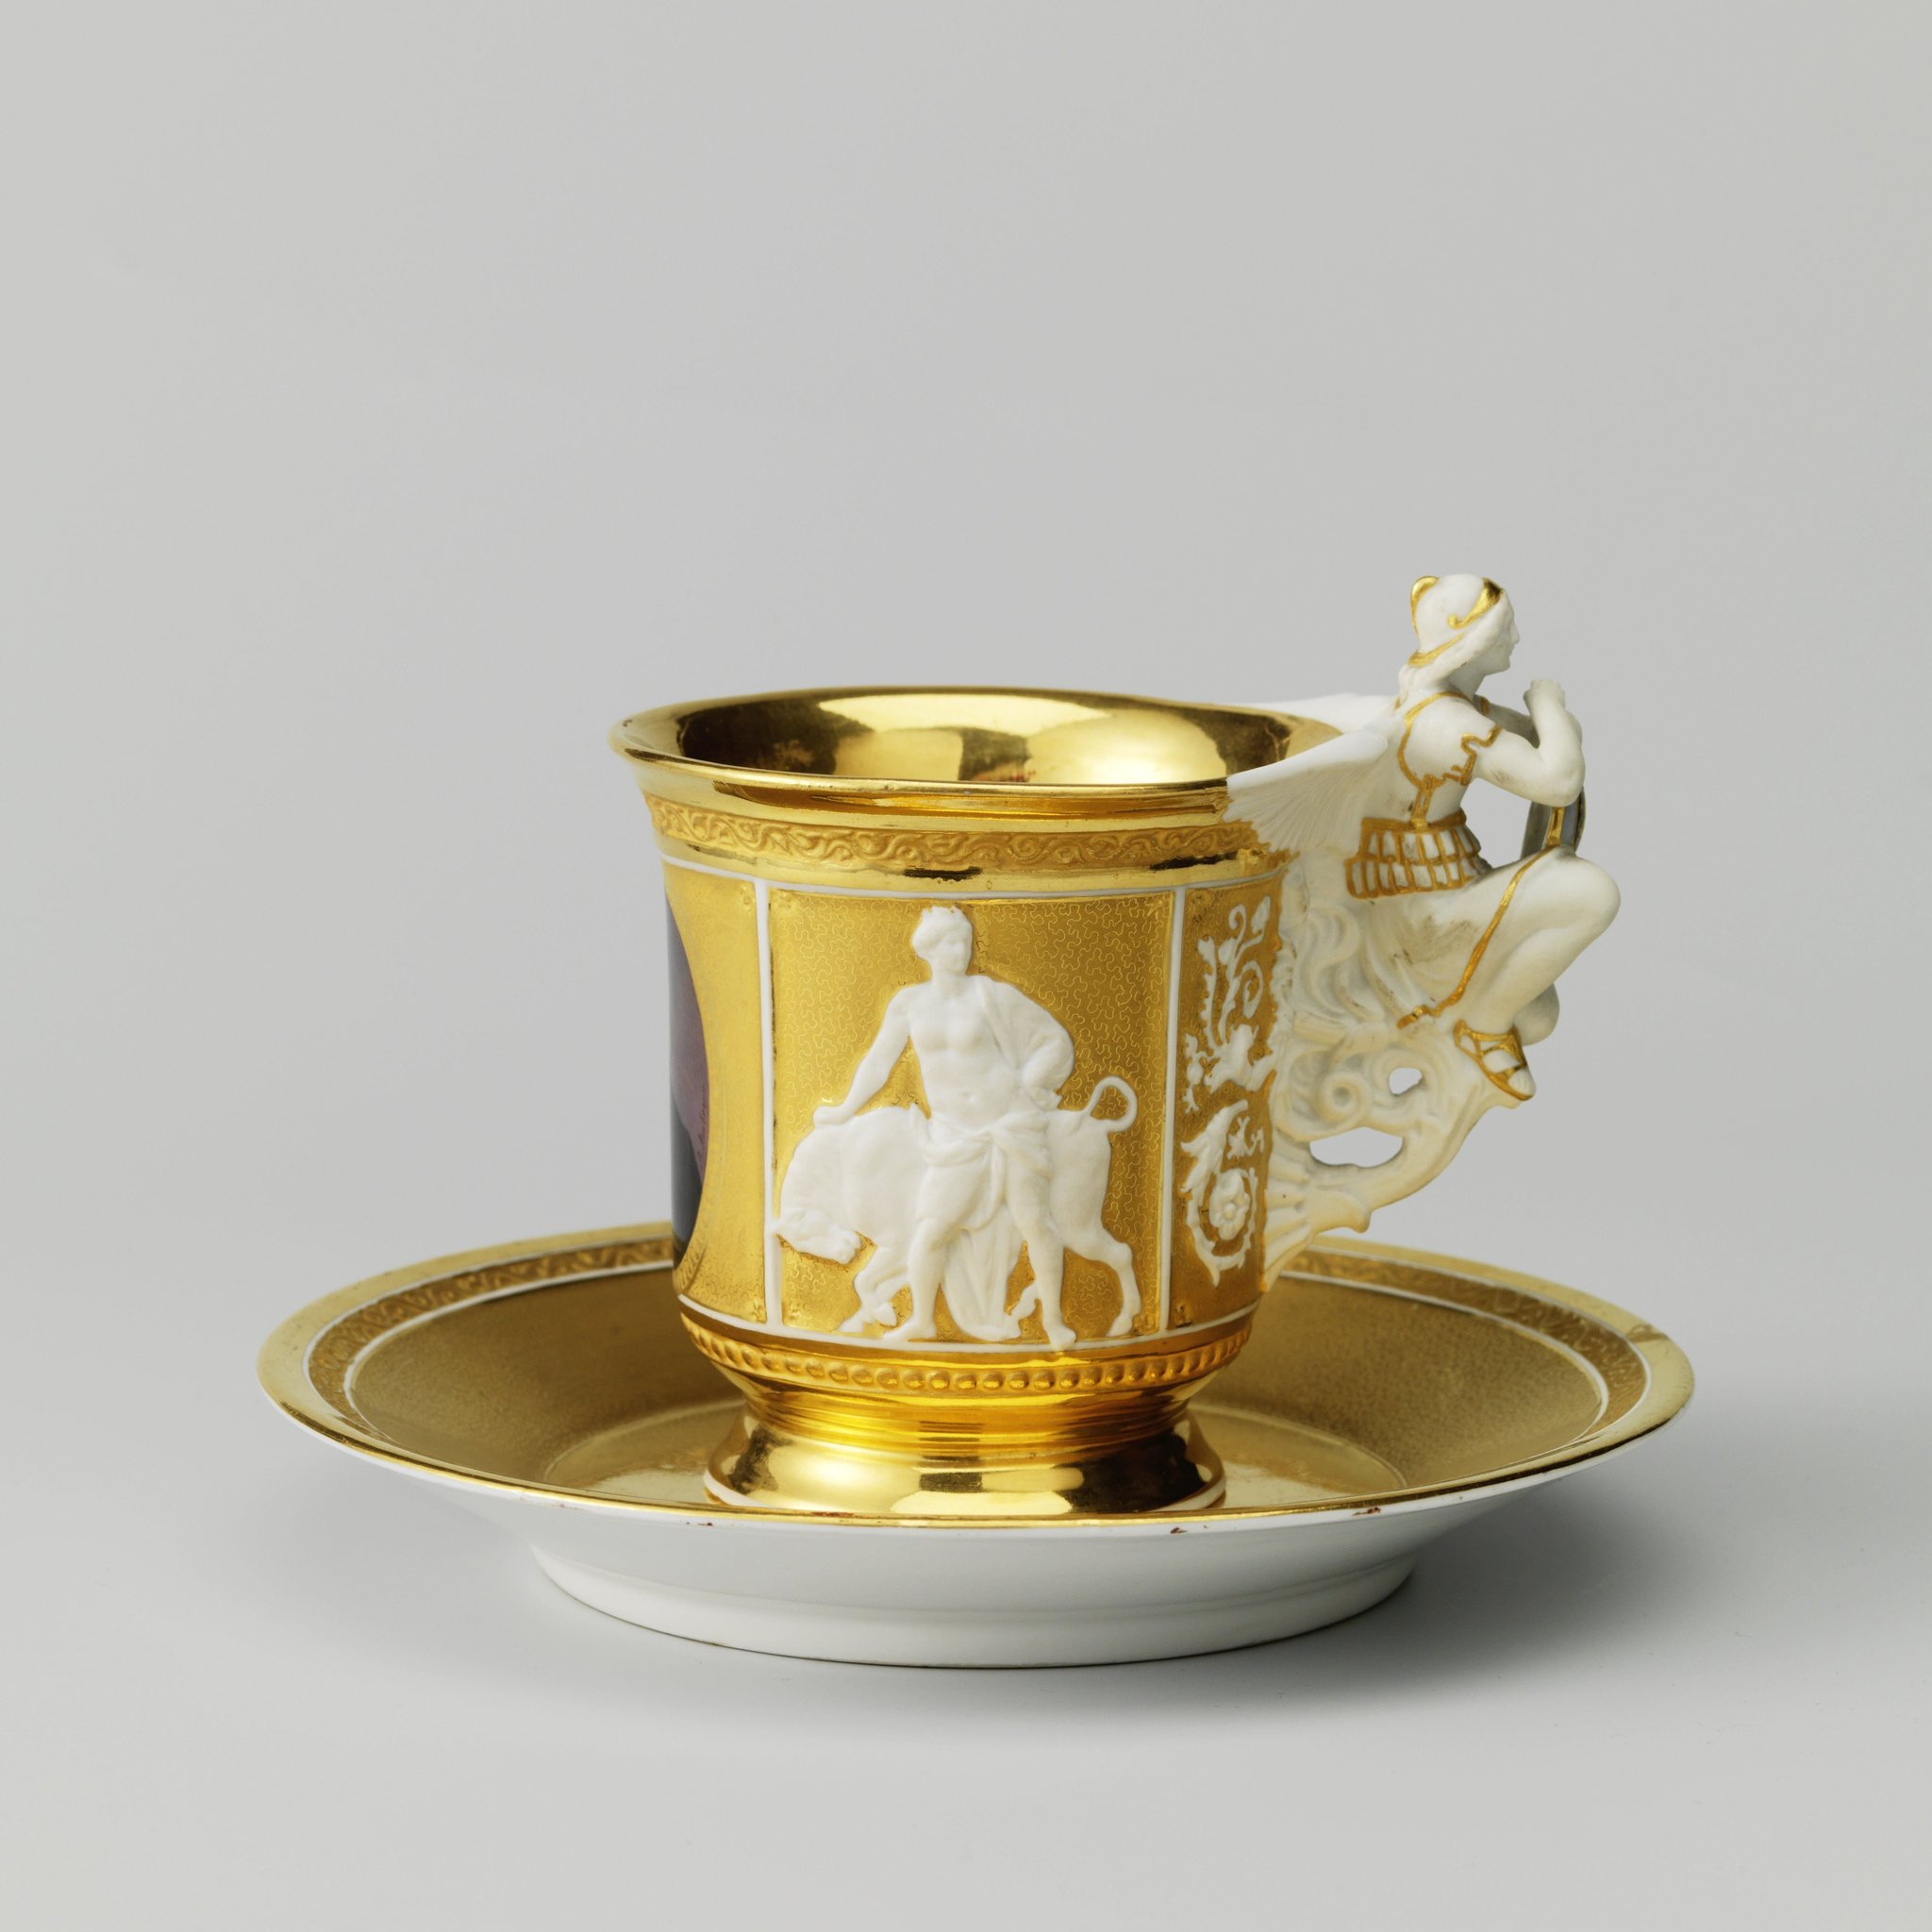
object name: kop en schotel, kop en schotel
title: Cup and saucer with the portrait of Philips, Count of Flanders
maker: a. ambronn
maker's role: painter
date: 1867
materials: glaze, gold, paint, porcelain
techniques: firing, forming, gilding, relief, turning, vitrification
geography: berlin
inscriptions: signature: ‘A. Ambronn’, mark: ‘scepter met adelaar in medaillon en KOENIGL. PORZELLAN MANUFAKTUR/ S/ D’, mark: ‘scepter met adelaar in medaillon en KOENIGL. PORZELLAN MANUFAKTUR/ M’, inscription: ‘NICHTS OHNE GOTT’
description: Two cups and saucers with portraits of Philip, Count of Flanders, and Maria von Hohenzollern-Sigmaringen. Porcelain. Berlin, Königliche Porzellan Manufaktur, ca. 1867.